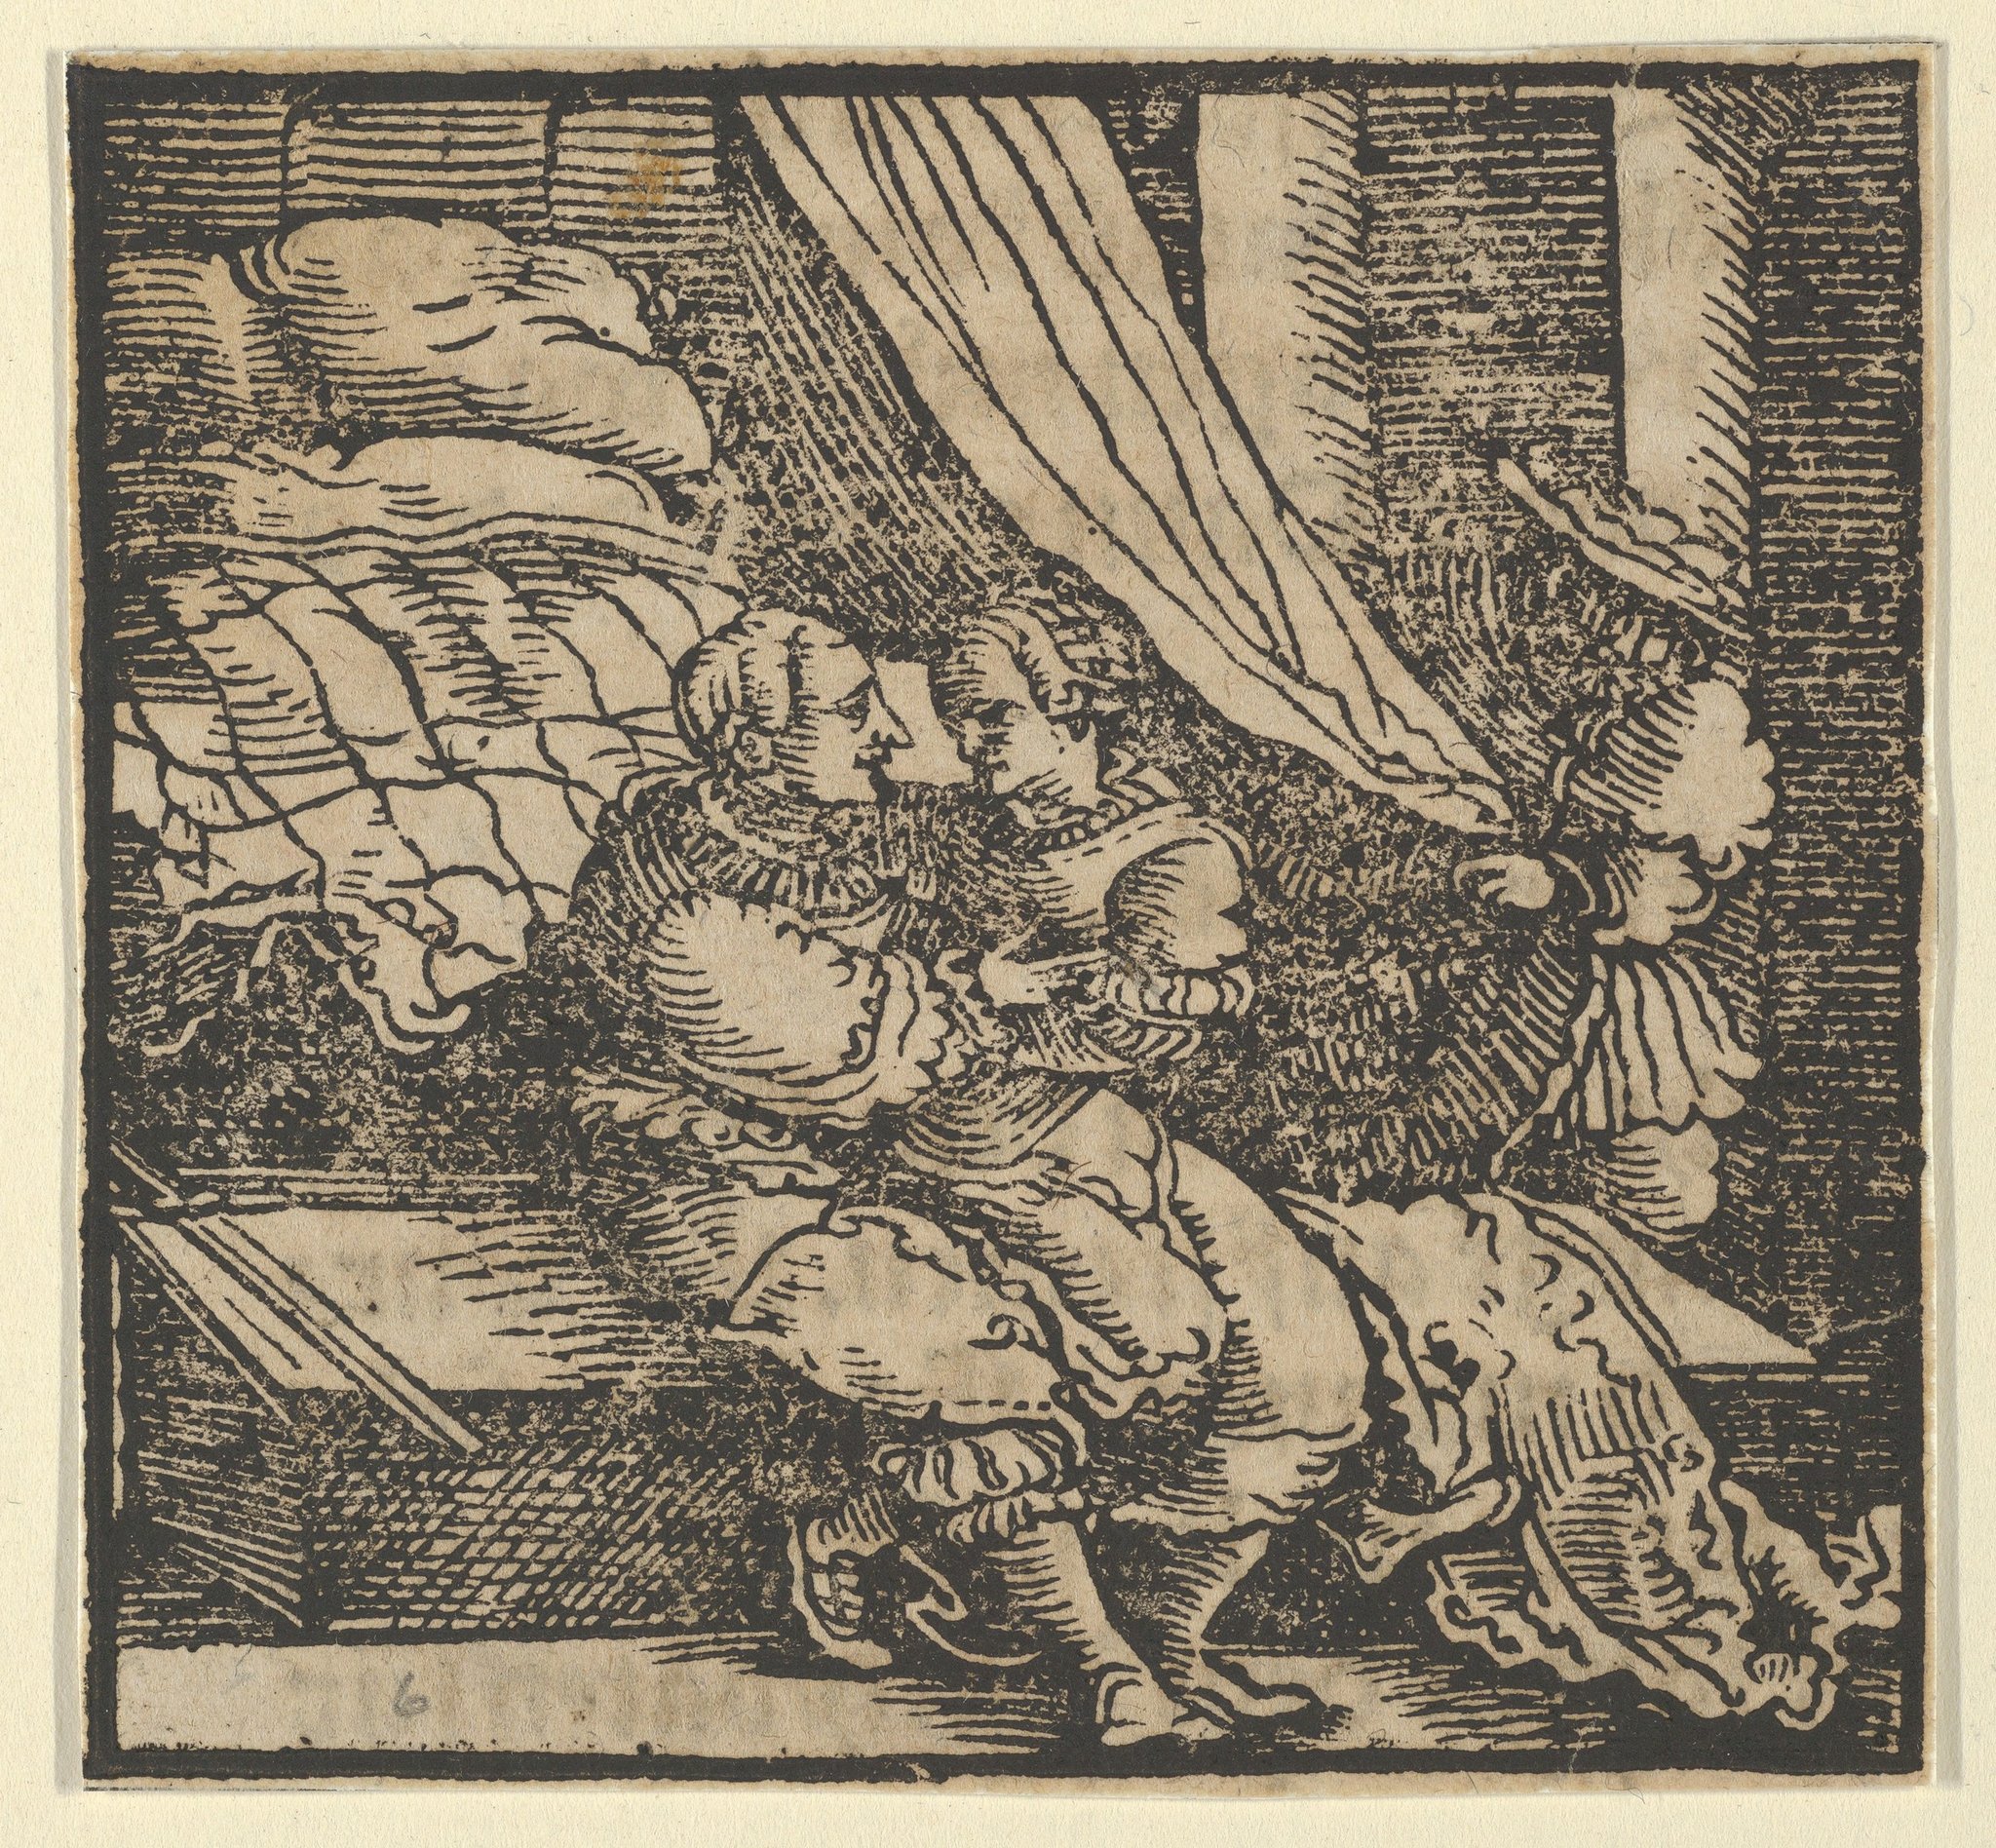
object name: print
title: Ghismonda, Guiscardo, and the Prince of Salerno, from The Decameron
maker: hans schäufelein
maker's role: artist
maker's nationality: german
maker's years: 1480-1540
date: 1534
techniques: woodcut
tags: princes,men,women